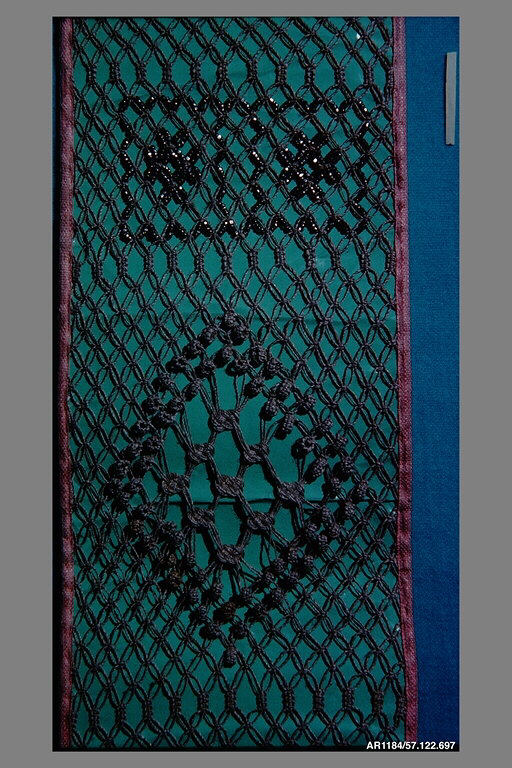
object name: sampler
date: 1801-1900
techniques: embroidery